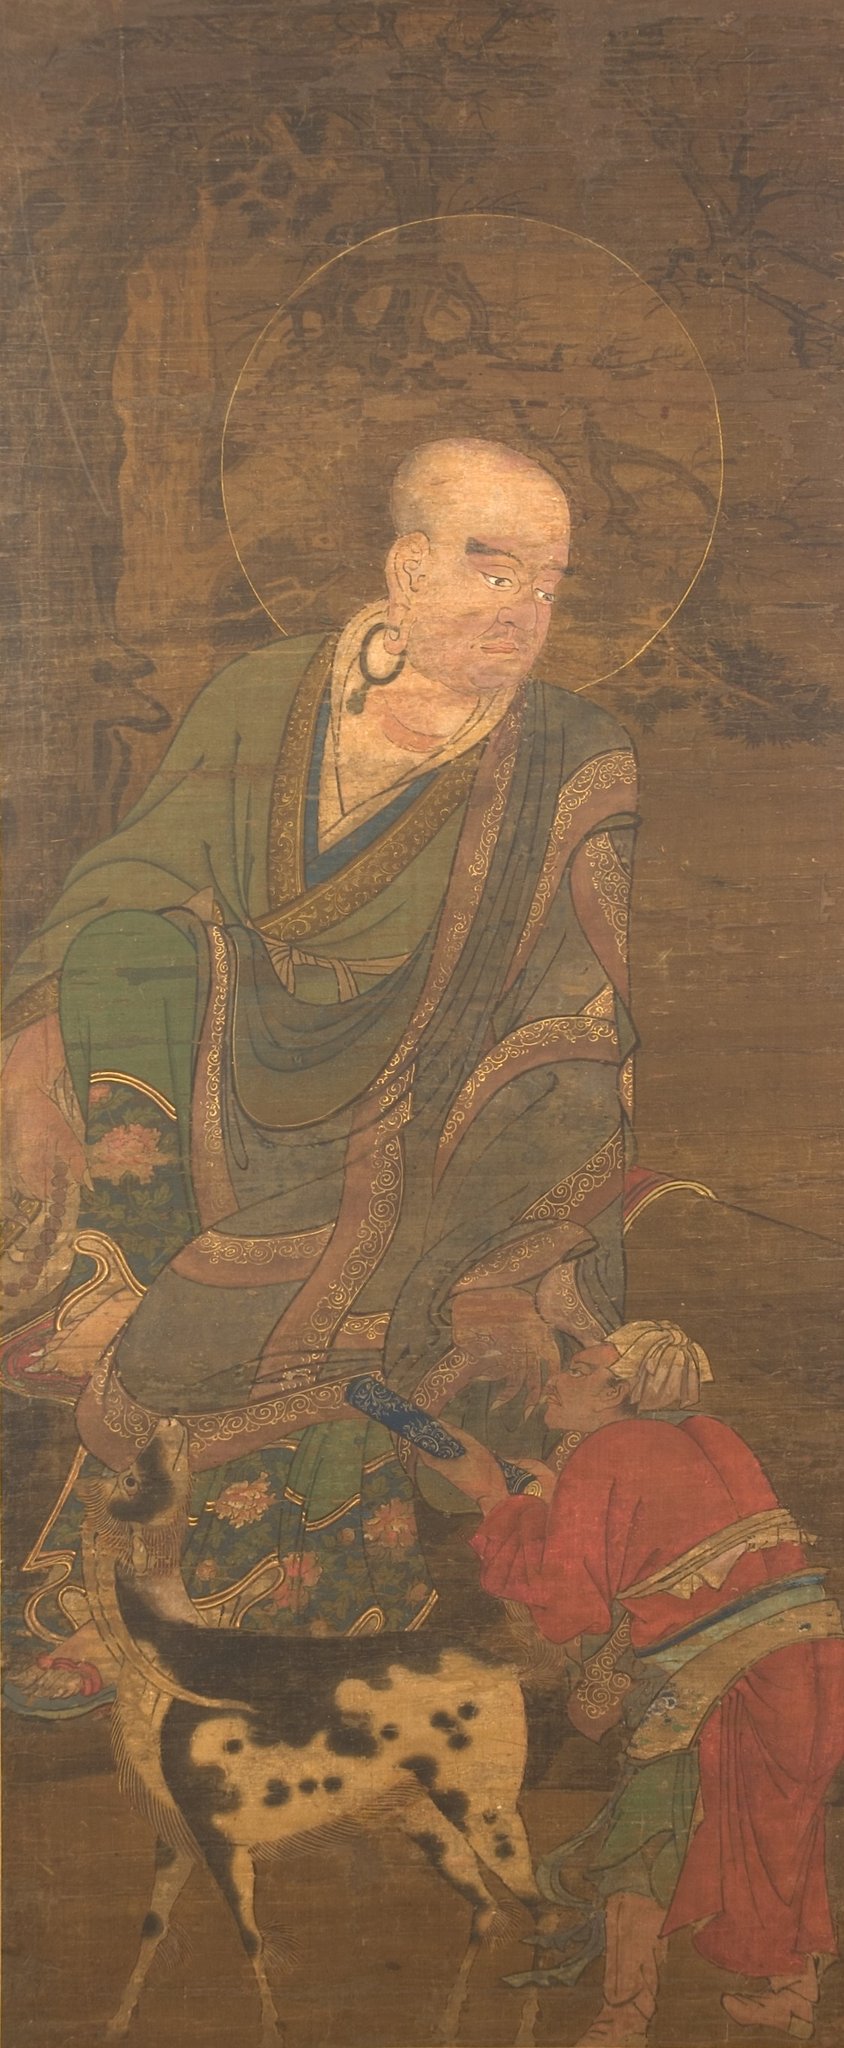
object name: hanging scroll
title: Rakan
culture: japanese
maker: unidentified artist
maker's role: artist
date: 1401-1600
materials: gold, ink, silk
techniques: cutting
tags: animals,men